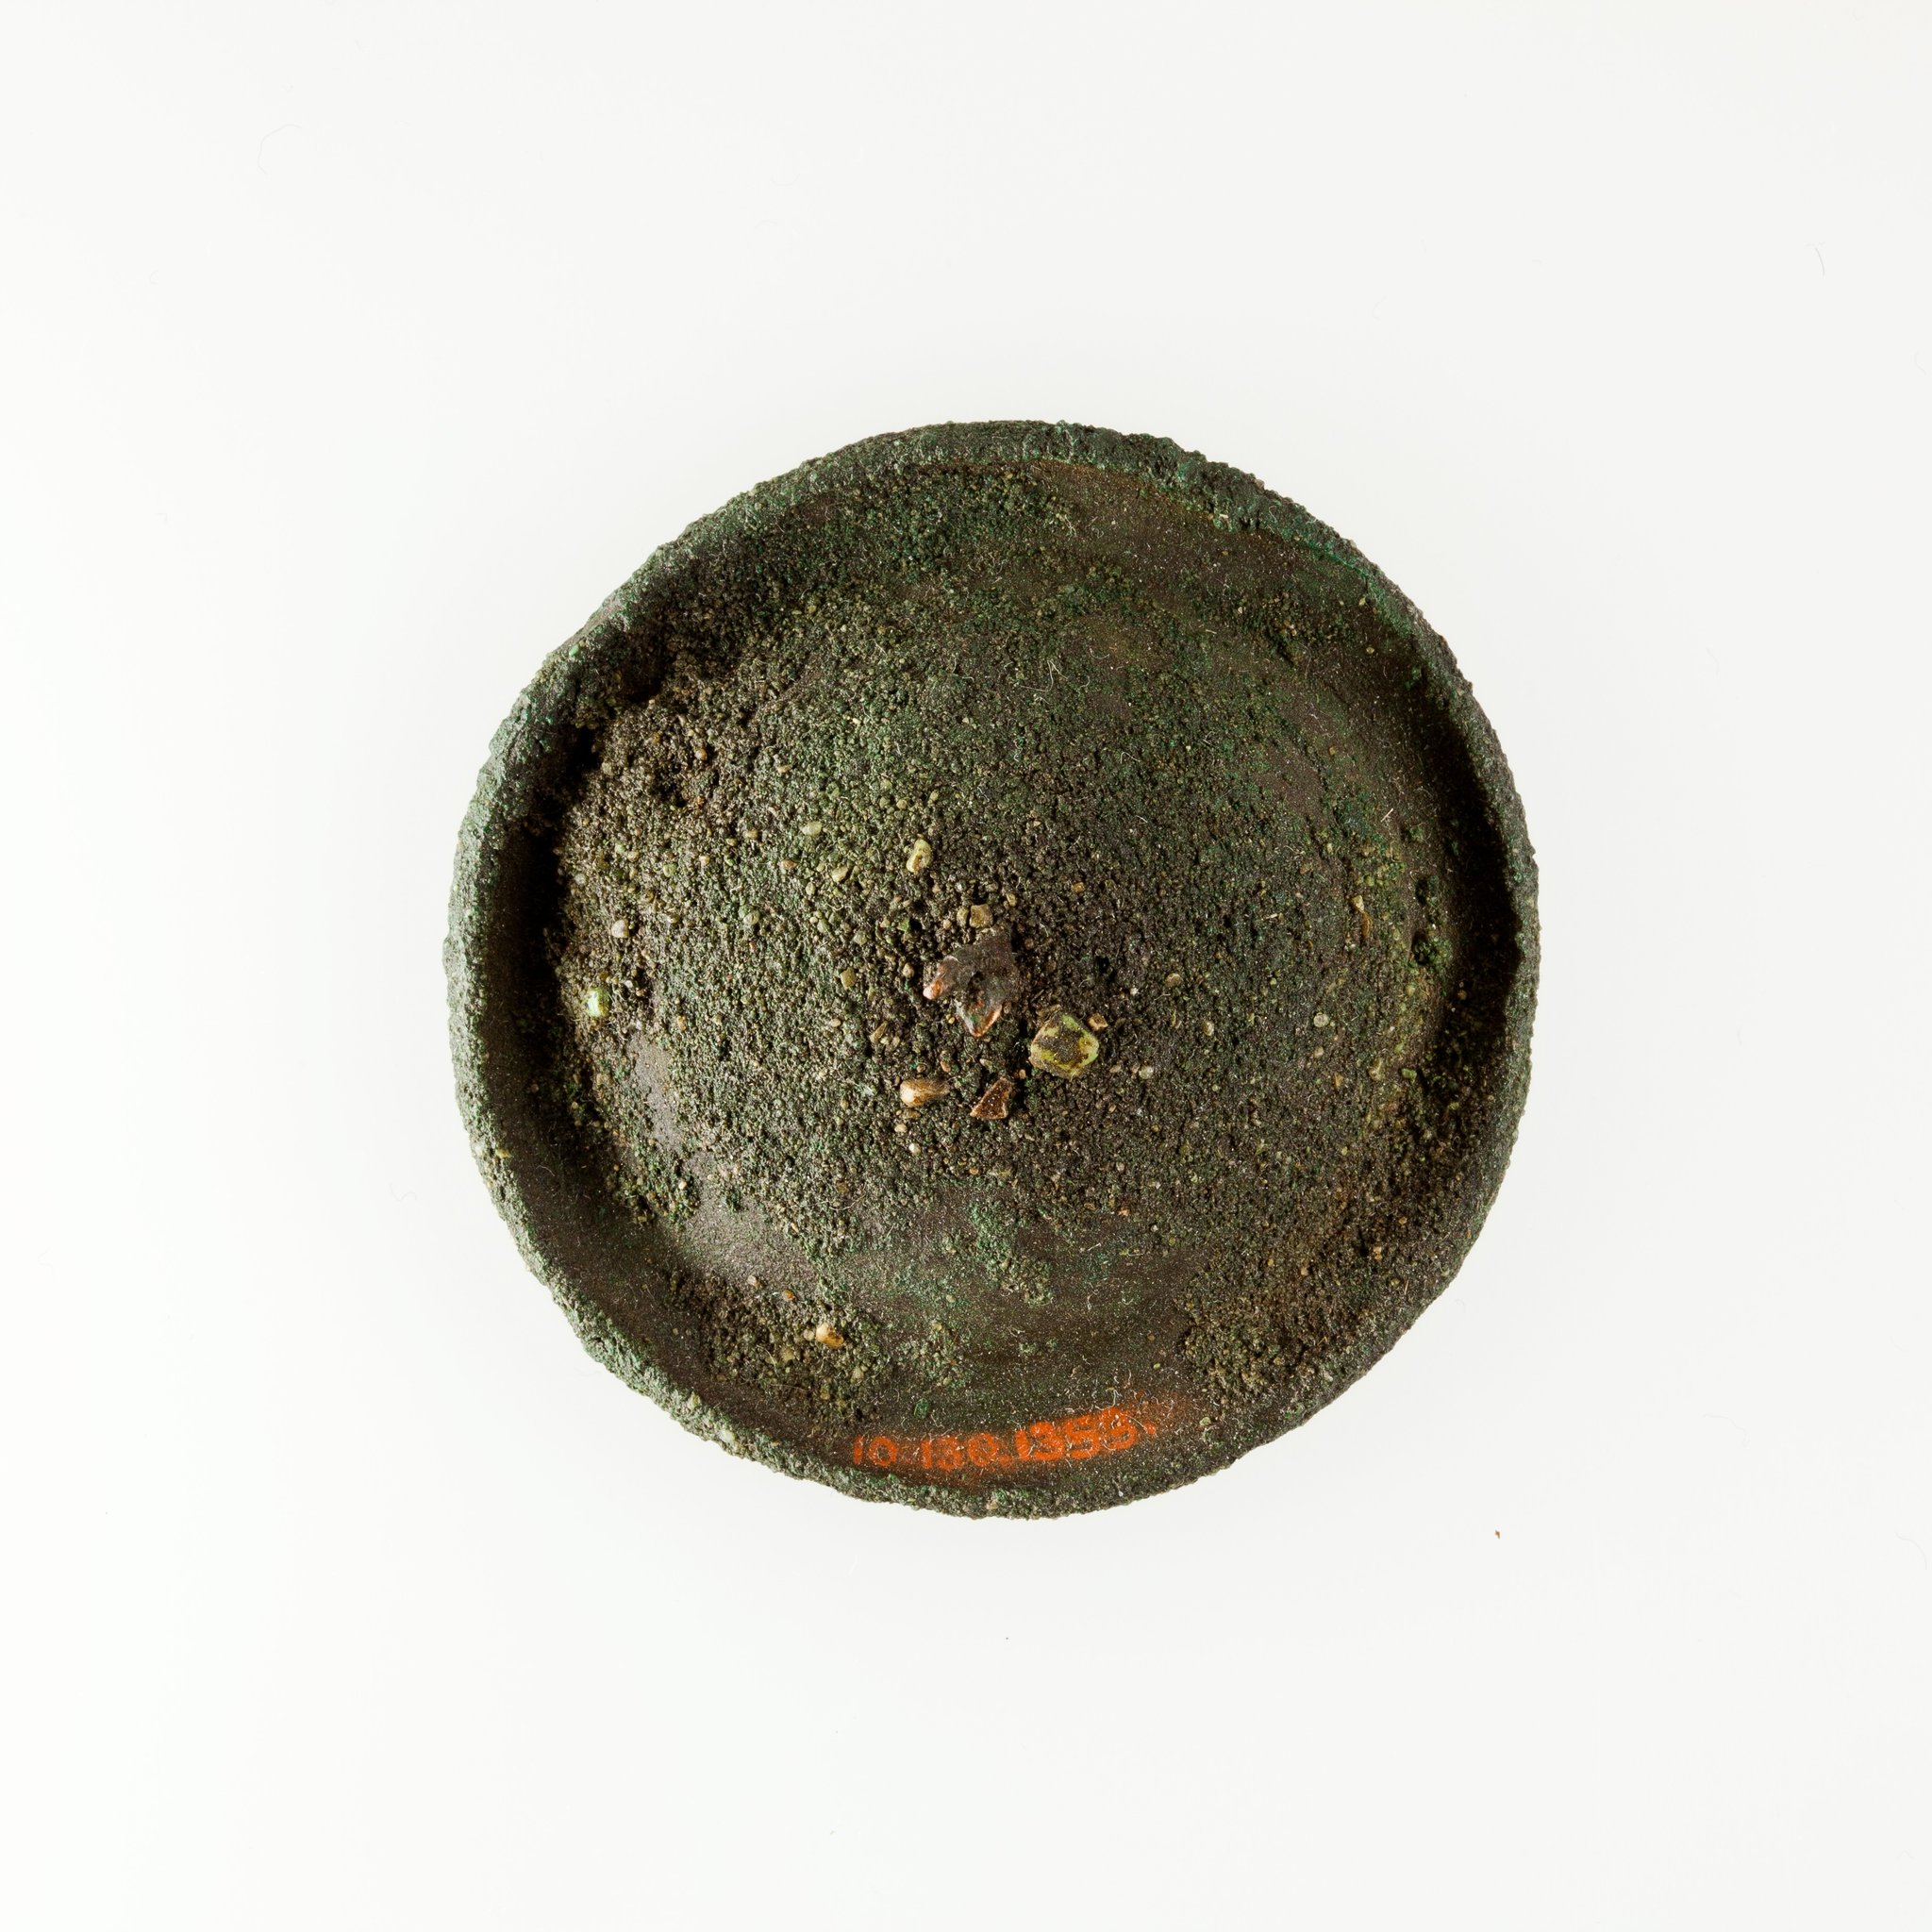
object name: music, cymbal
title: Cymbal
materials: copper alloy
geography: egypt